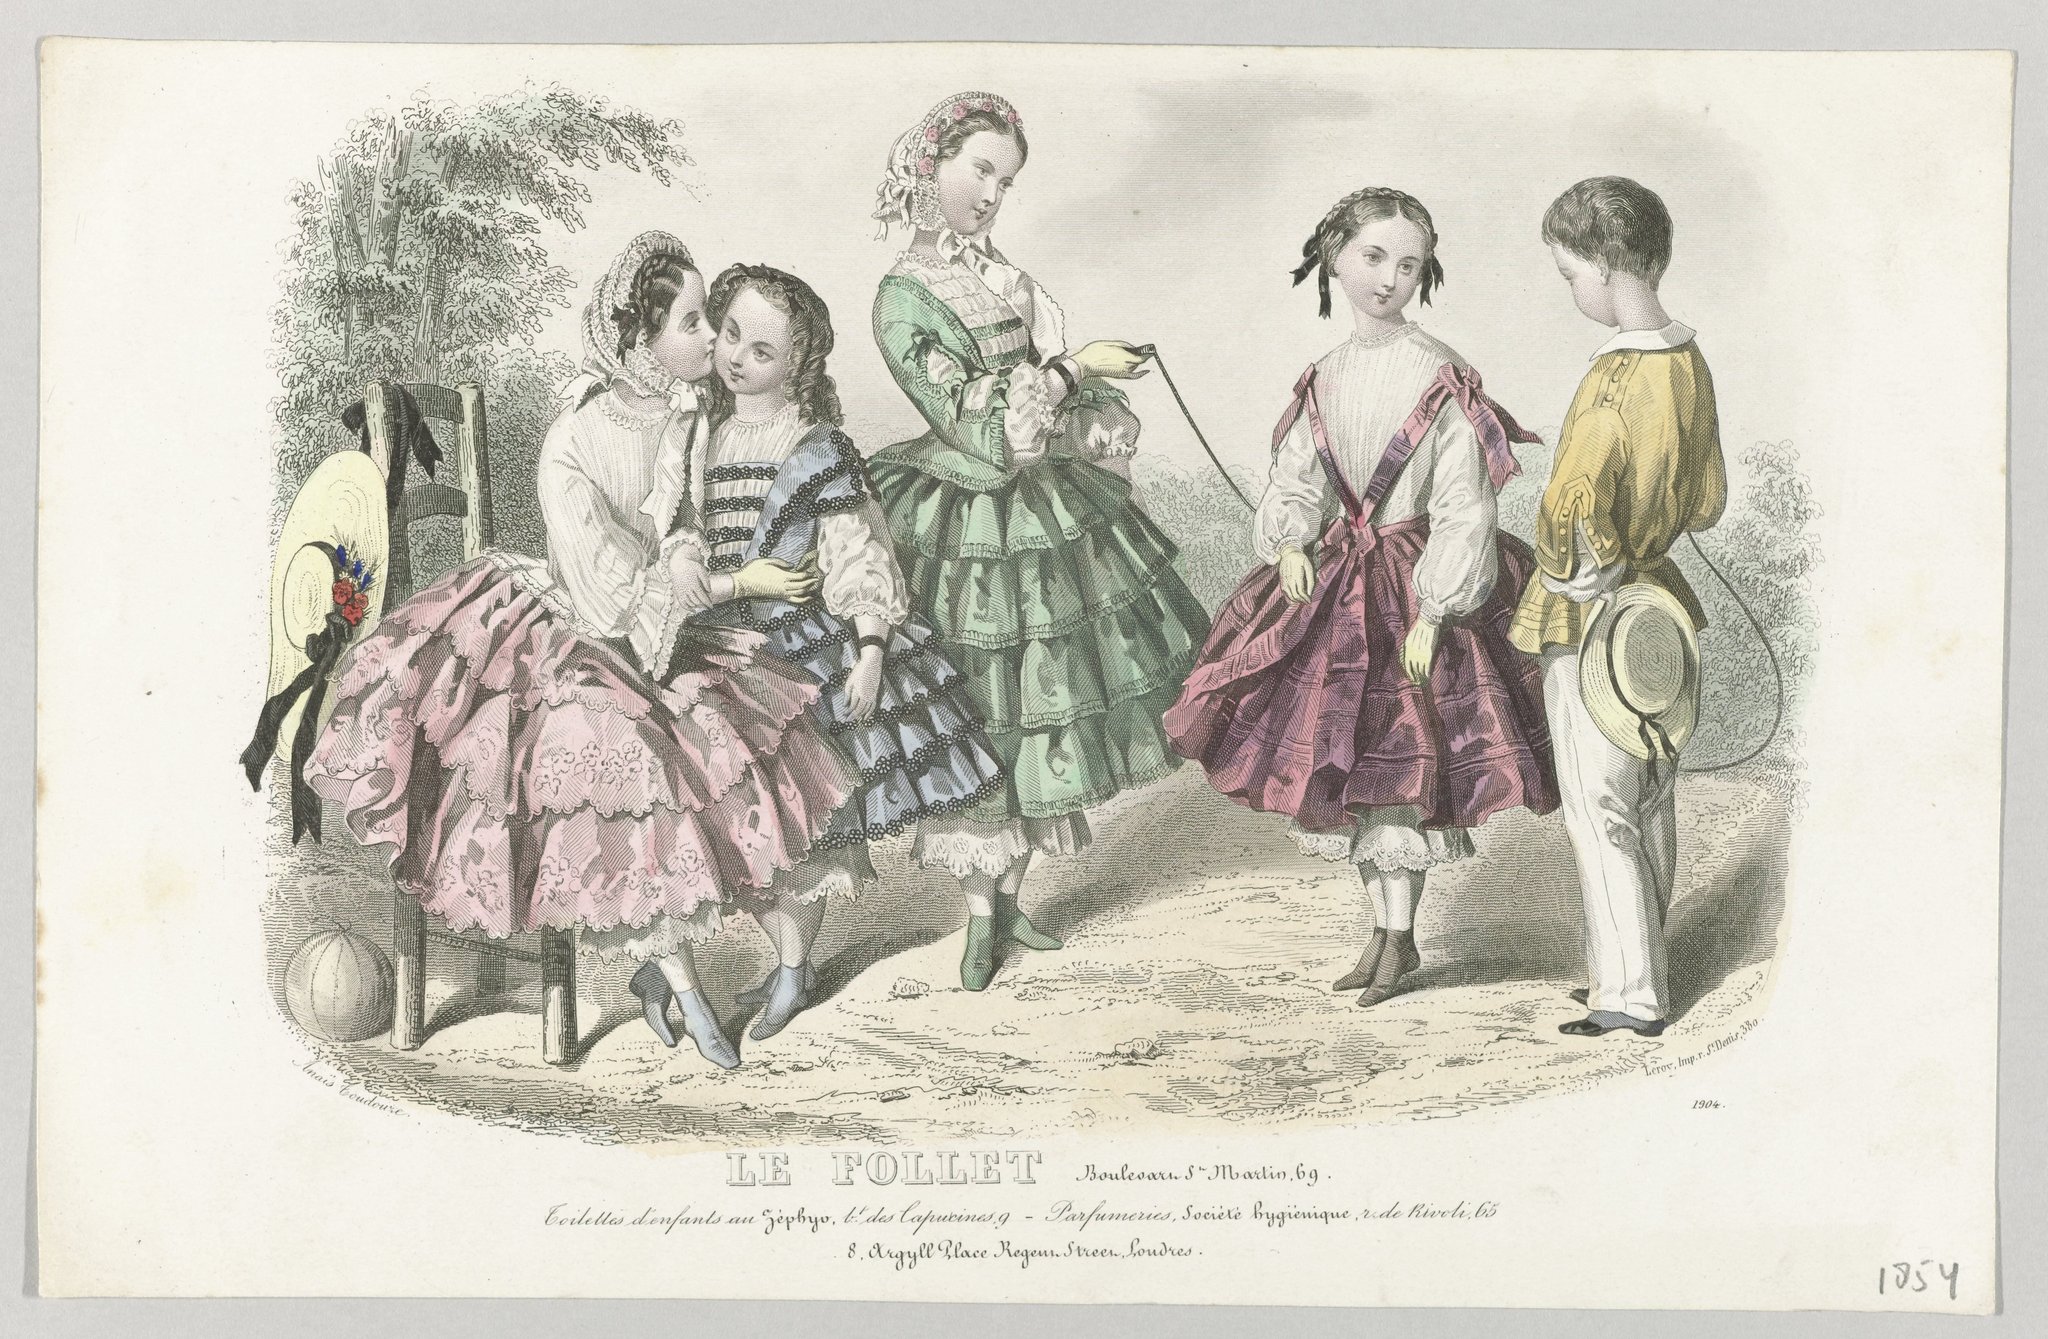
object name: fashion print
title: Le Follet, 1854, No. 1904 : Toilettes d'enfants (...)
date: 1854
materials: paper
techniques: engraving, hand coloring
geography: paris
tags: clothes, costume (+ children's clothes), head-gear: cap (+ children's clothes), dress, gown (+ children's clothes), fashion plates, jumping-rope games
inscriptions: caption: ‘Toilettes d'enfants au Zéphyr, b.t des Capucines. 9 - Parfumeries, Société Hygiénique, r. ed Rivoli, 65’, title: ‘Le Follet’, address: ‘Boulevart S.t Martin, 69 / 8, Argyll Place, Regent Street, Londres.’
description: Vier meisjes en een jongen in een park, spelend met een springtouw. Onder de voorstelling enkele regels reclametekst voor verschillende producten. Prent uit het modetijdschrift Le Follet Courrier des Salons (novembre 1829- octobre 1882).